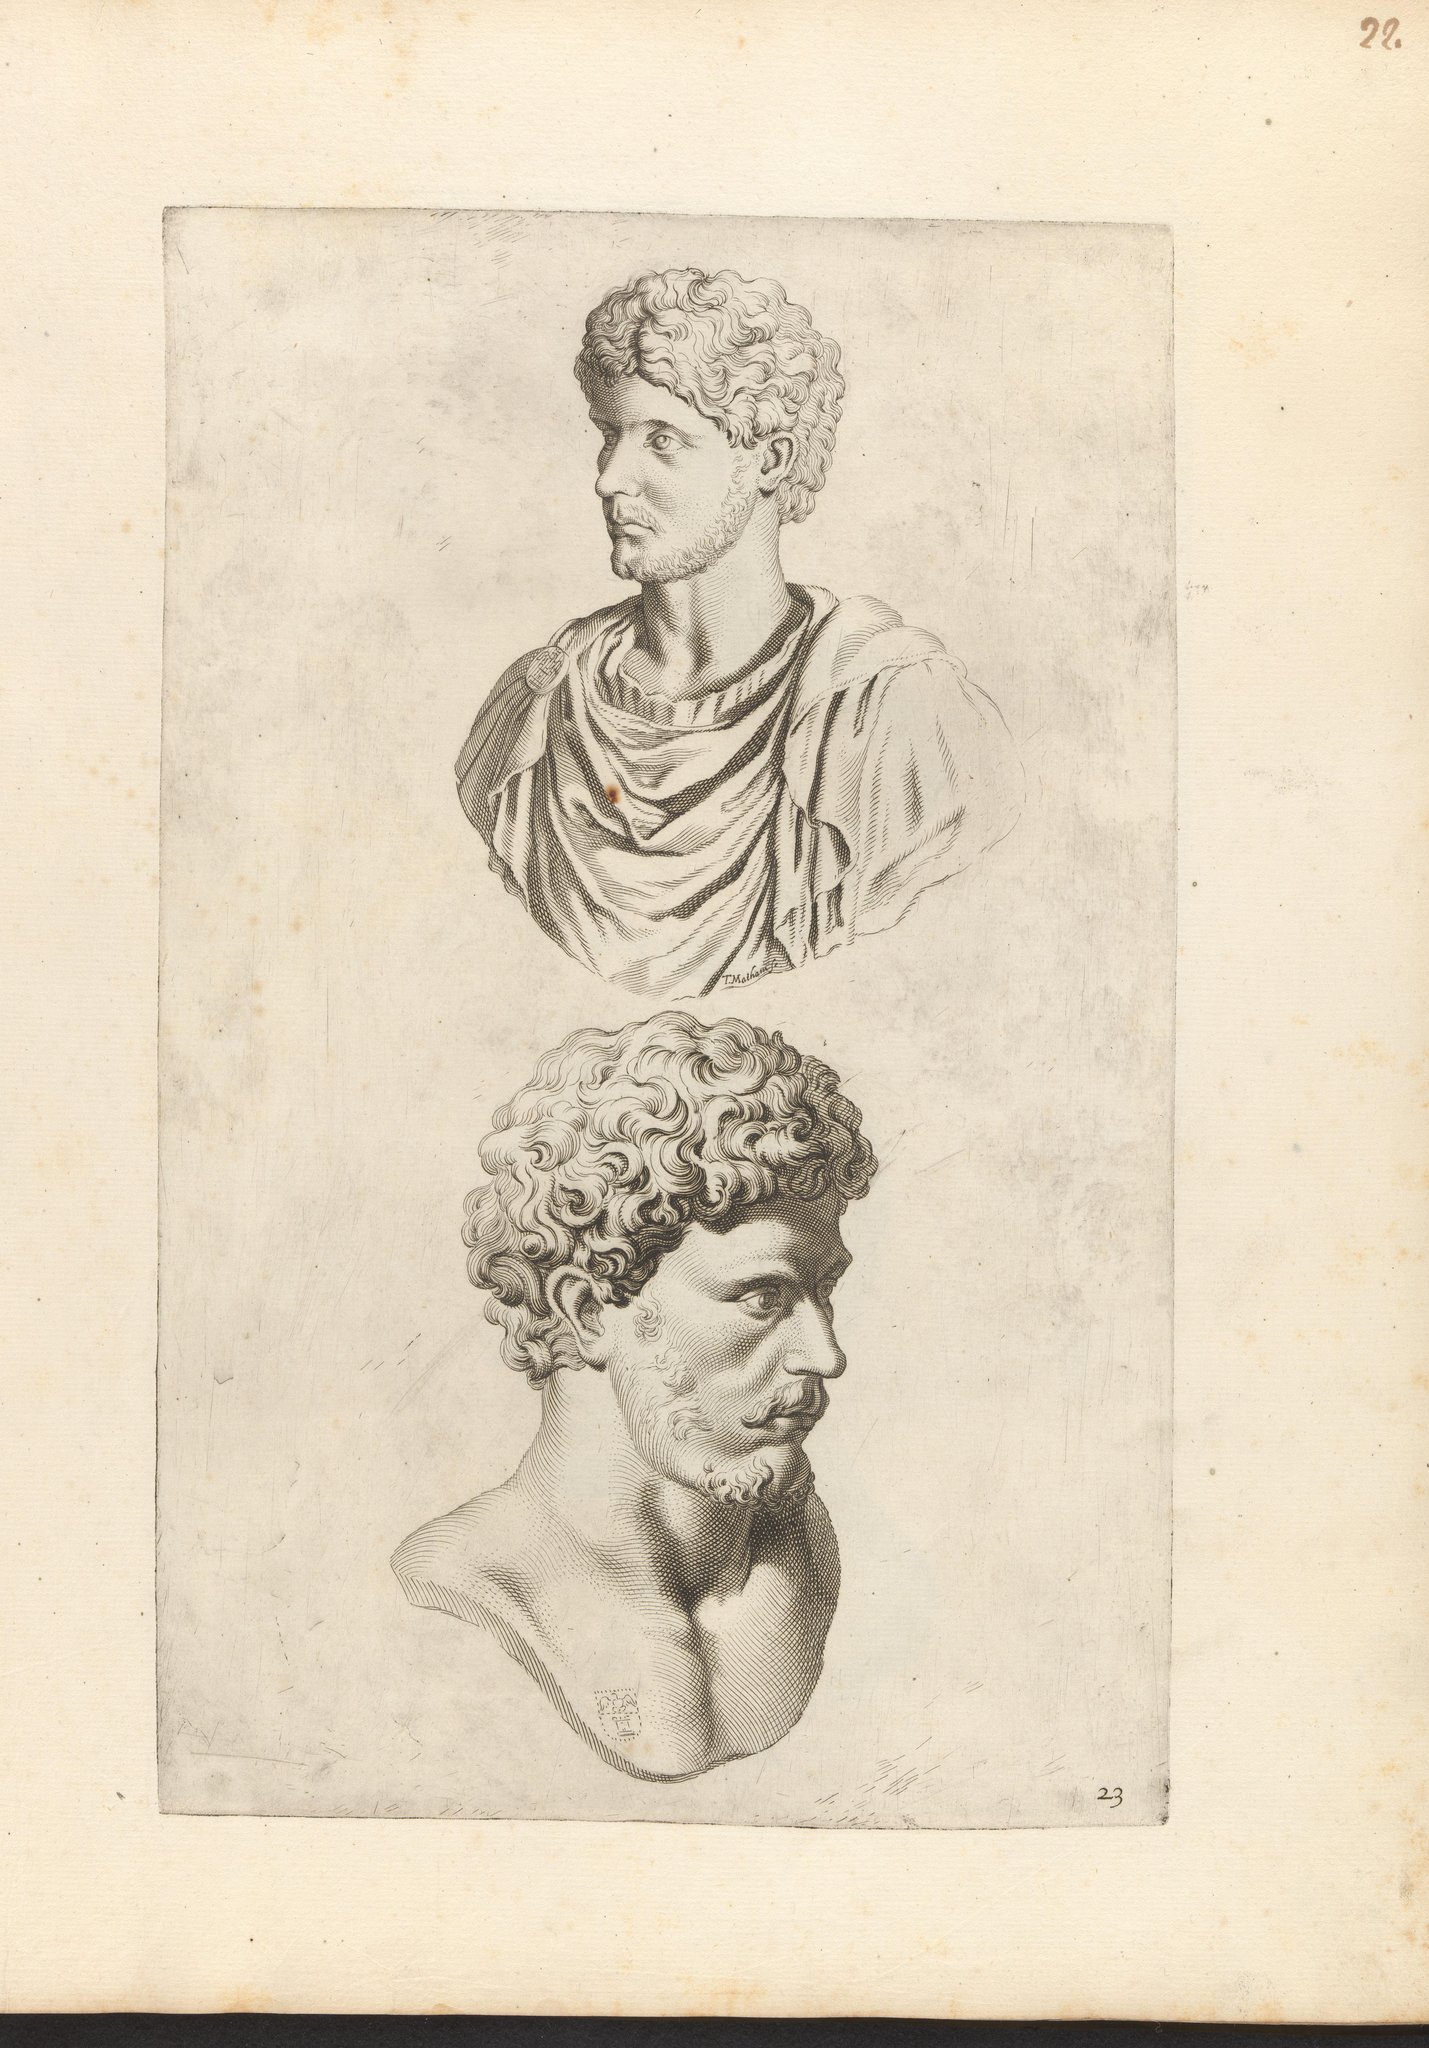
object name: album leaf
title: Galleria Giustiniana del Marchese Vincenzo Giustiniani II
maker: theodor matham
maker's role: draughtsman, print maker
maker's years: 1605-1676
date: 1636-1647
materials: paper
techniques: engraving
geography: rome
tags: male persons from classical history (+ head, bust, etc.), piece of sculpture, reproduction of a piece of sculpture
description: Twee bustes van keizer Lucius Aelius Verus. Op de onderste buste het wapenschild van Vincenzo Giustiniani. Prent maakt deel uit van een album met een serie prenten naar de sculpturen in de verzameling in de Galleria Giustiniani te Rome.